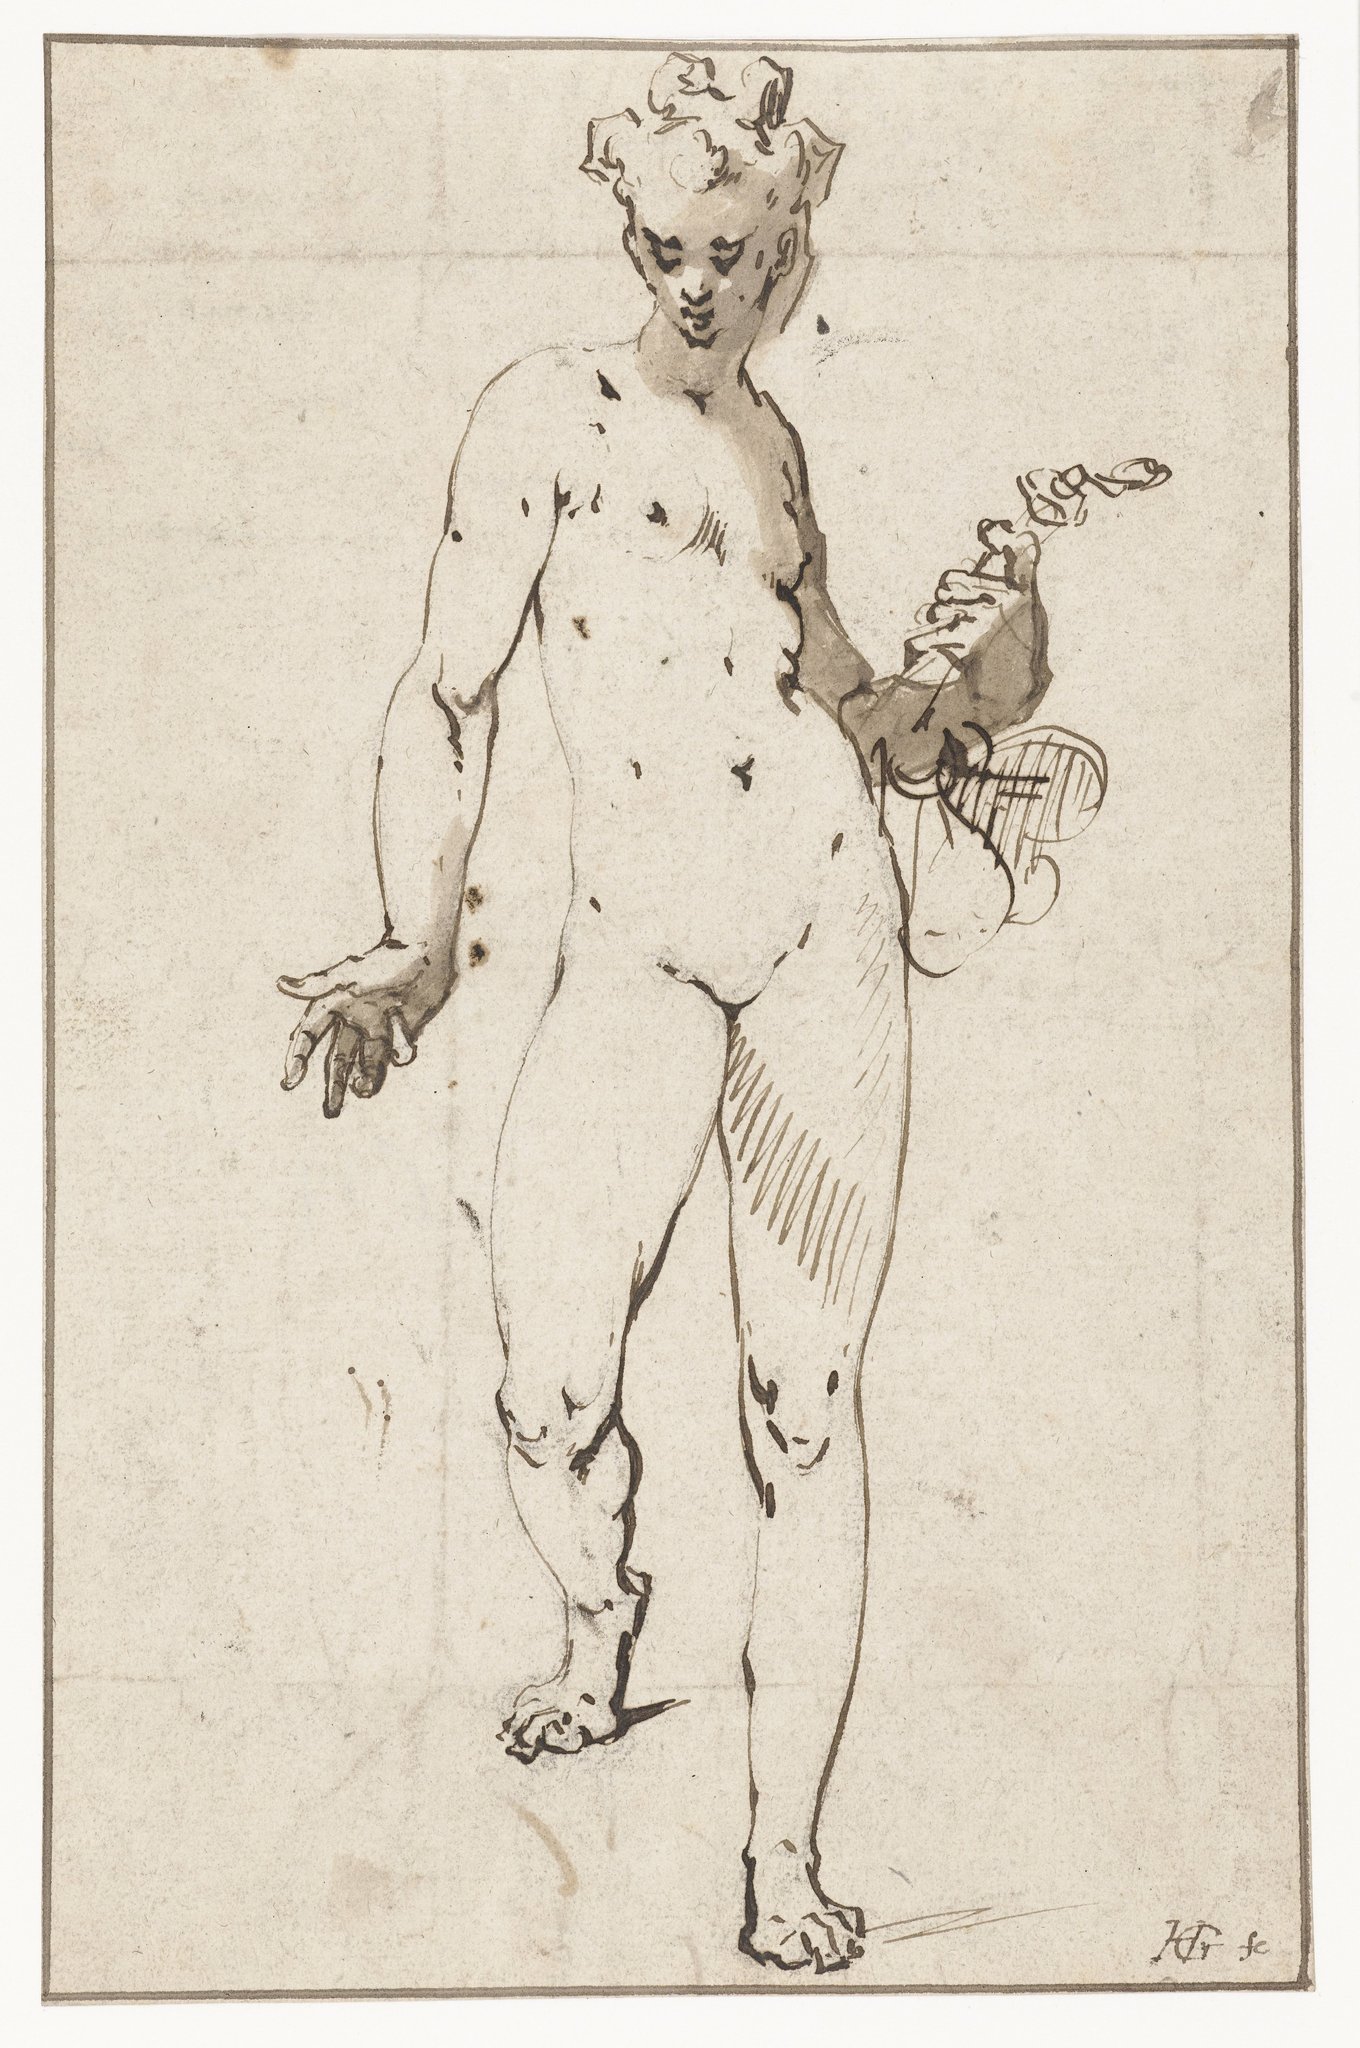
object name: drawing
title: Standing Female nude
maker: hendrick goltzius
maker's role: draughtsman, painter, print maker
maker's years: 1558-1617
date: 1586-1590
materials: paper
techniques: brush, pen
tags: purse, money-bag, standing figure - aa - female human figure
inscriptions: signature: ‘HG’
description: Reznicek suggereert dat het een afbeelding is van Parsimonia vanwege het jeugdige uiterlijk van de vrouw. Echter, Parsimonia wordt op de gravures van Ph. Galle naar Heemskerck anders afgebeeld in de series 'Divitum misera sors' (Kerrich, 1829, p. 86, 2). Het is waarschijnlijker dat hier Fortuna bedoeld wordt, die ook met een geldbuidel afgebeeld wordt.